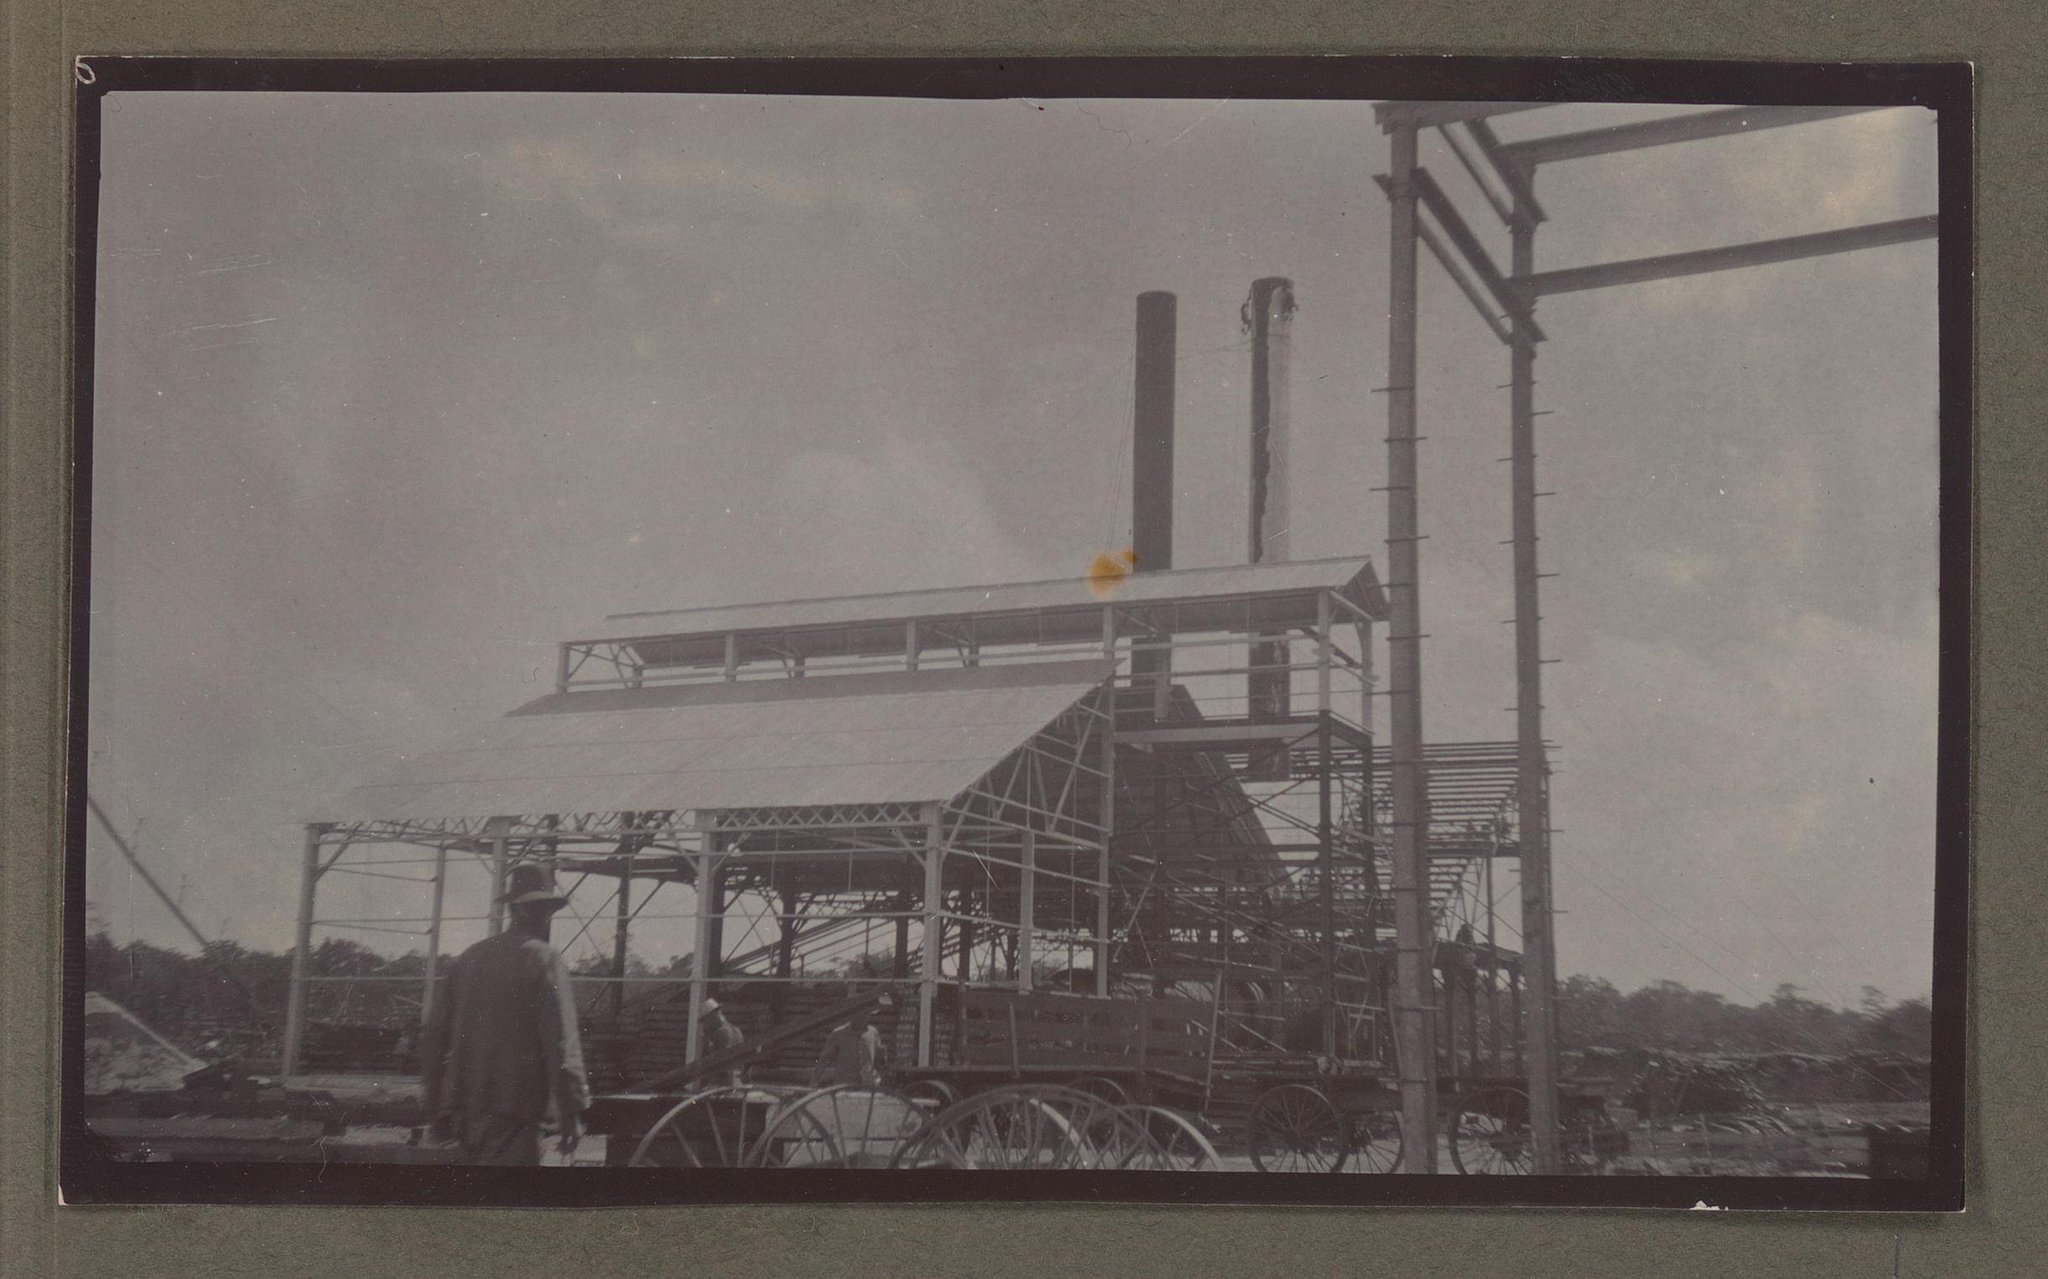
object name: photograph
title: Mijn en fabriek in Moengo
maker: Anonymous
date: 1925-1927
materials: photographic support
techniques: photography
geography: suriname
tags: jetten, familie, moengo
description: Terrein van de mijn en fabriek in Moengo. Foto op een bladzijde van een los albumblad. Onderdeel van het ensemble met foto's van de familie van ingenieur Jetten in de mijnbouwstad Moengo in Suriname.